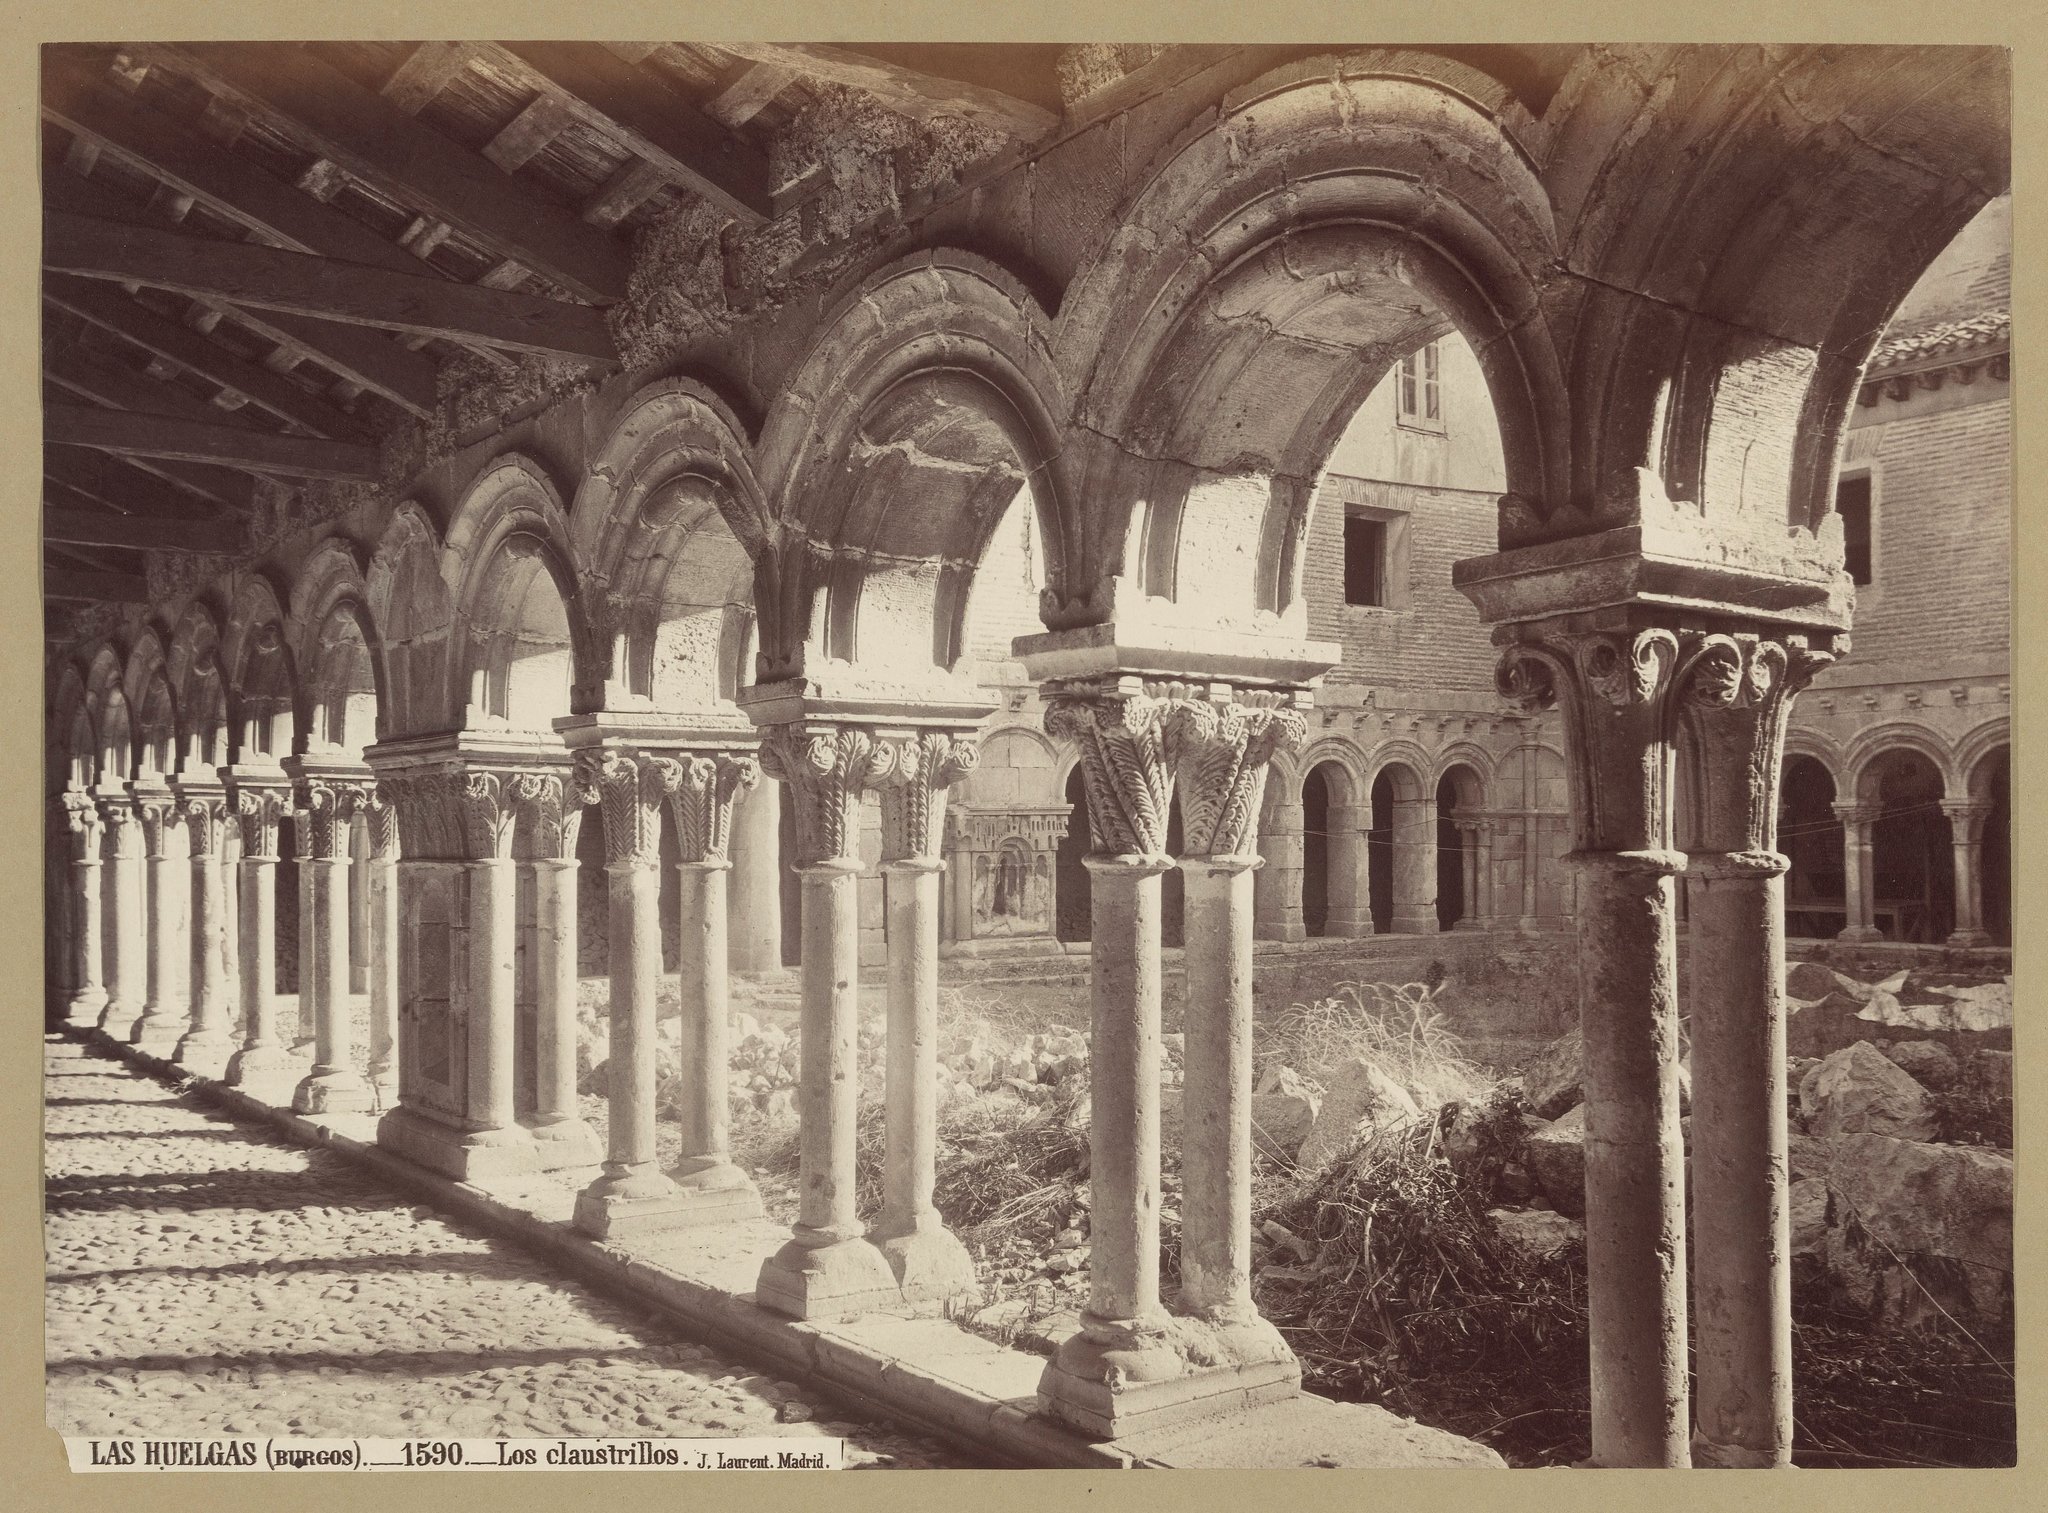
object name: photograph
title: Las Huelgas (Burgos), los claustrillos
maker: juan laurent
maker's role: publisher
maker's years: 1816-1896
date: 1856-1863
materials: paper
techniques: albumen print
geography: burgos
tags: parts of church interior: ambulatory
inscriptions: number: ‘1590.’